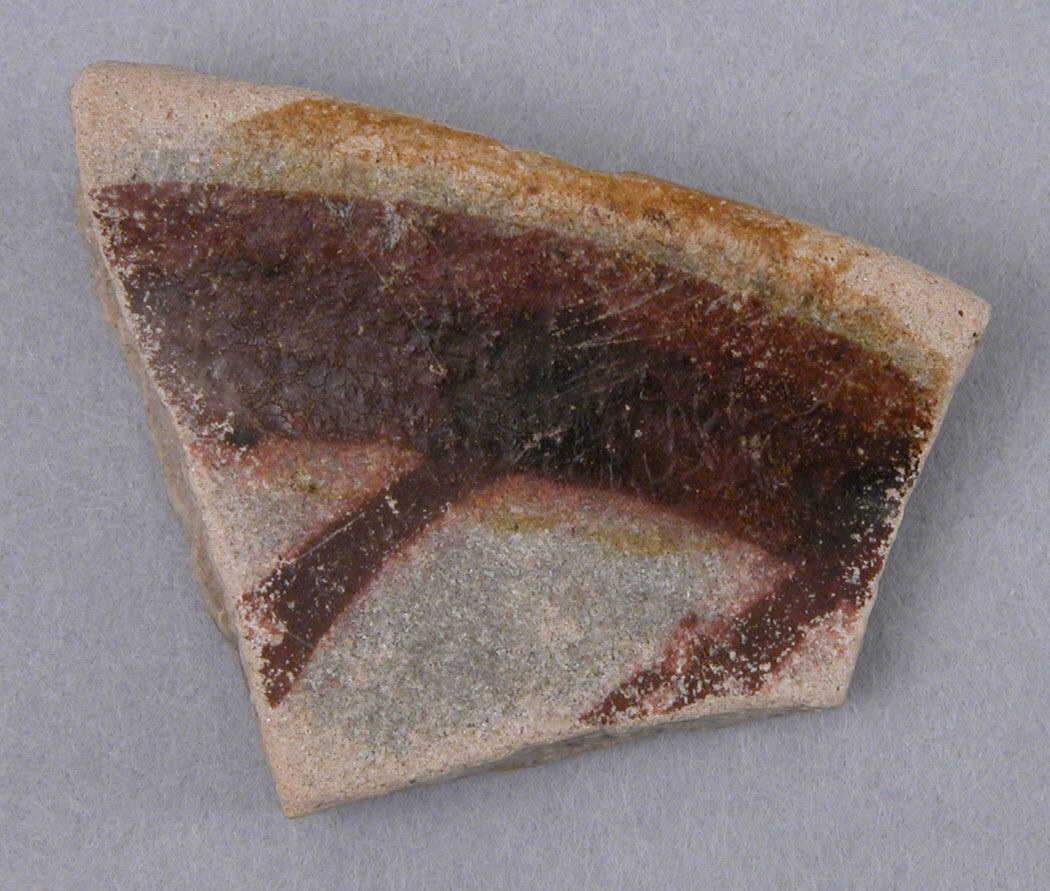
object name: fragment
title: Ceramic Fragment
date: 801-900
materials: earthenware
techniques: glazing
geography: saudi arabia